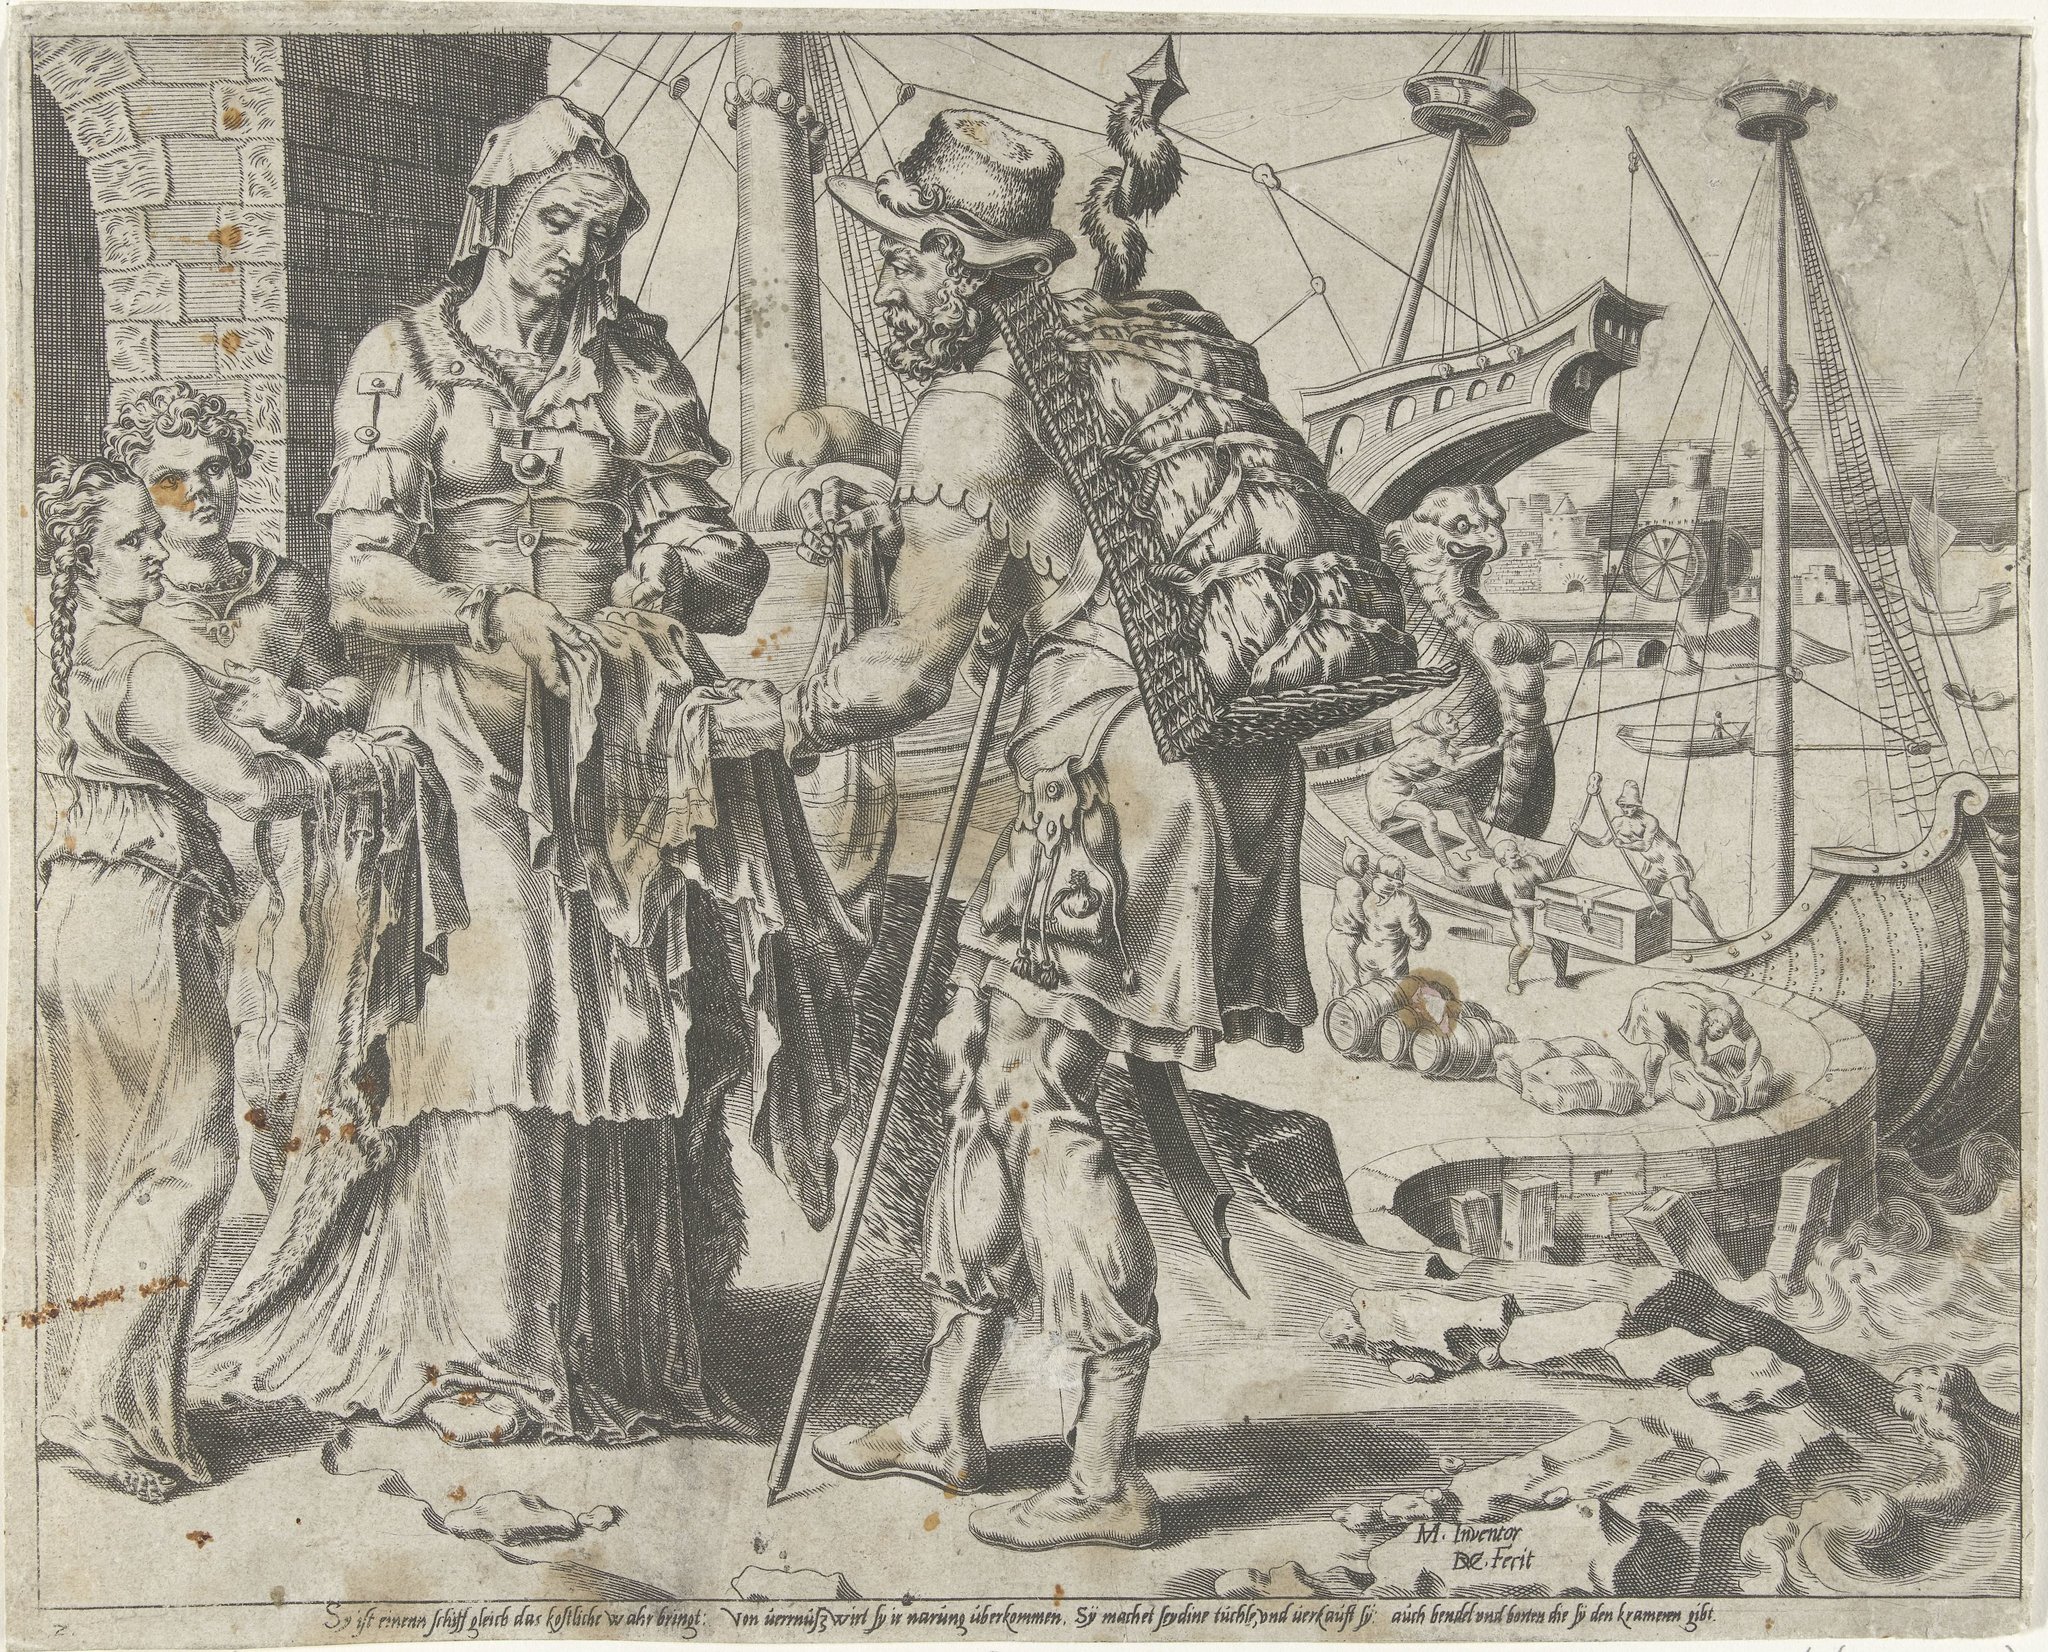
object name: print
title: De Deugdzame vrouw verkoopt haar waren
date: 1555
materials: paper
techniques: engraving, etching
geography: haarlem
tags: pedlar, pier, quay, wharf, selling, ideal wife, the book of proverbs (with book chapter:verse)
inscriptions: collector's mark: Lugt 2228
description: De deugdzame vrouw verkoopt aan een handelaar kleren die ze zelf heeft gemaakt. In de achtergrond wordt een schip uitgeladen aan de kade. De prent is gebaseerd op Spreuken 31:14: 'Zoals een koopmansschip naar verre streken vaart, zo haalt zij van verre wat ze nodig heeft' en Spreuken 31:24: 'Zij vervaardigt kleding en gordels, en levert die aan kooplui'. De afbeelding heeft een Duits onderschrift en maakt deel uit van een zesdelige prentserie die de bezigheden van de deugdzame huisvrouw looft.